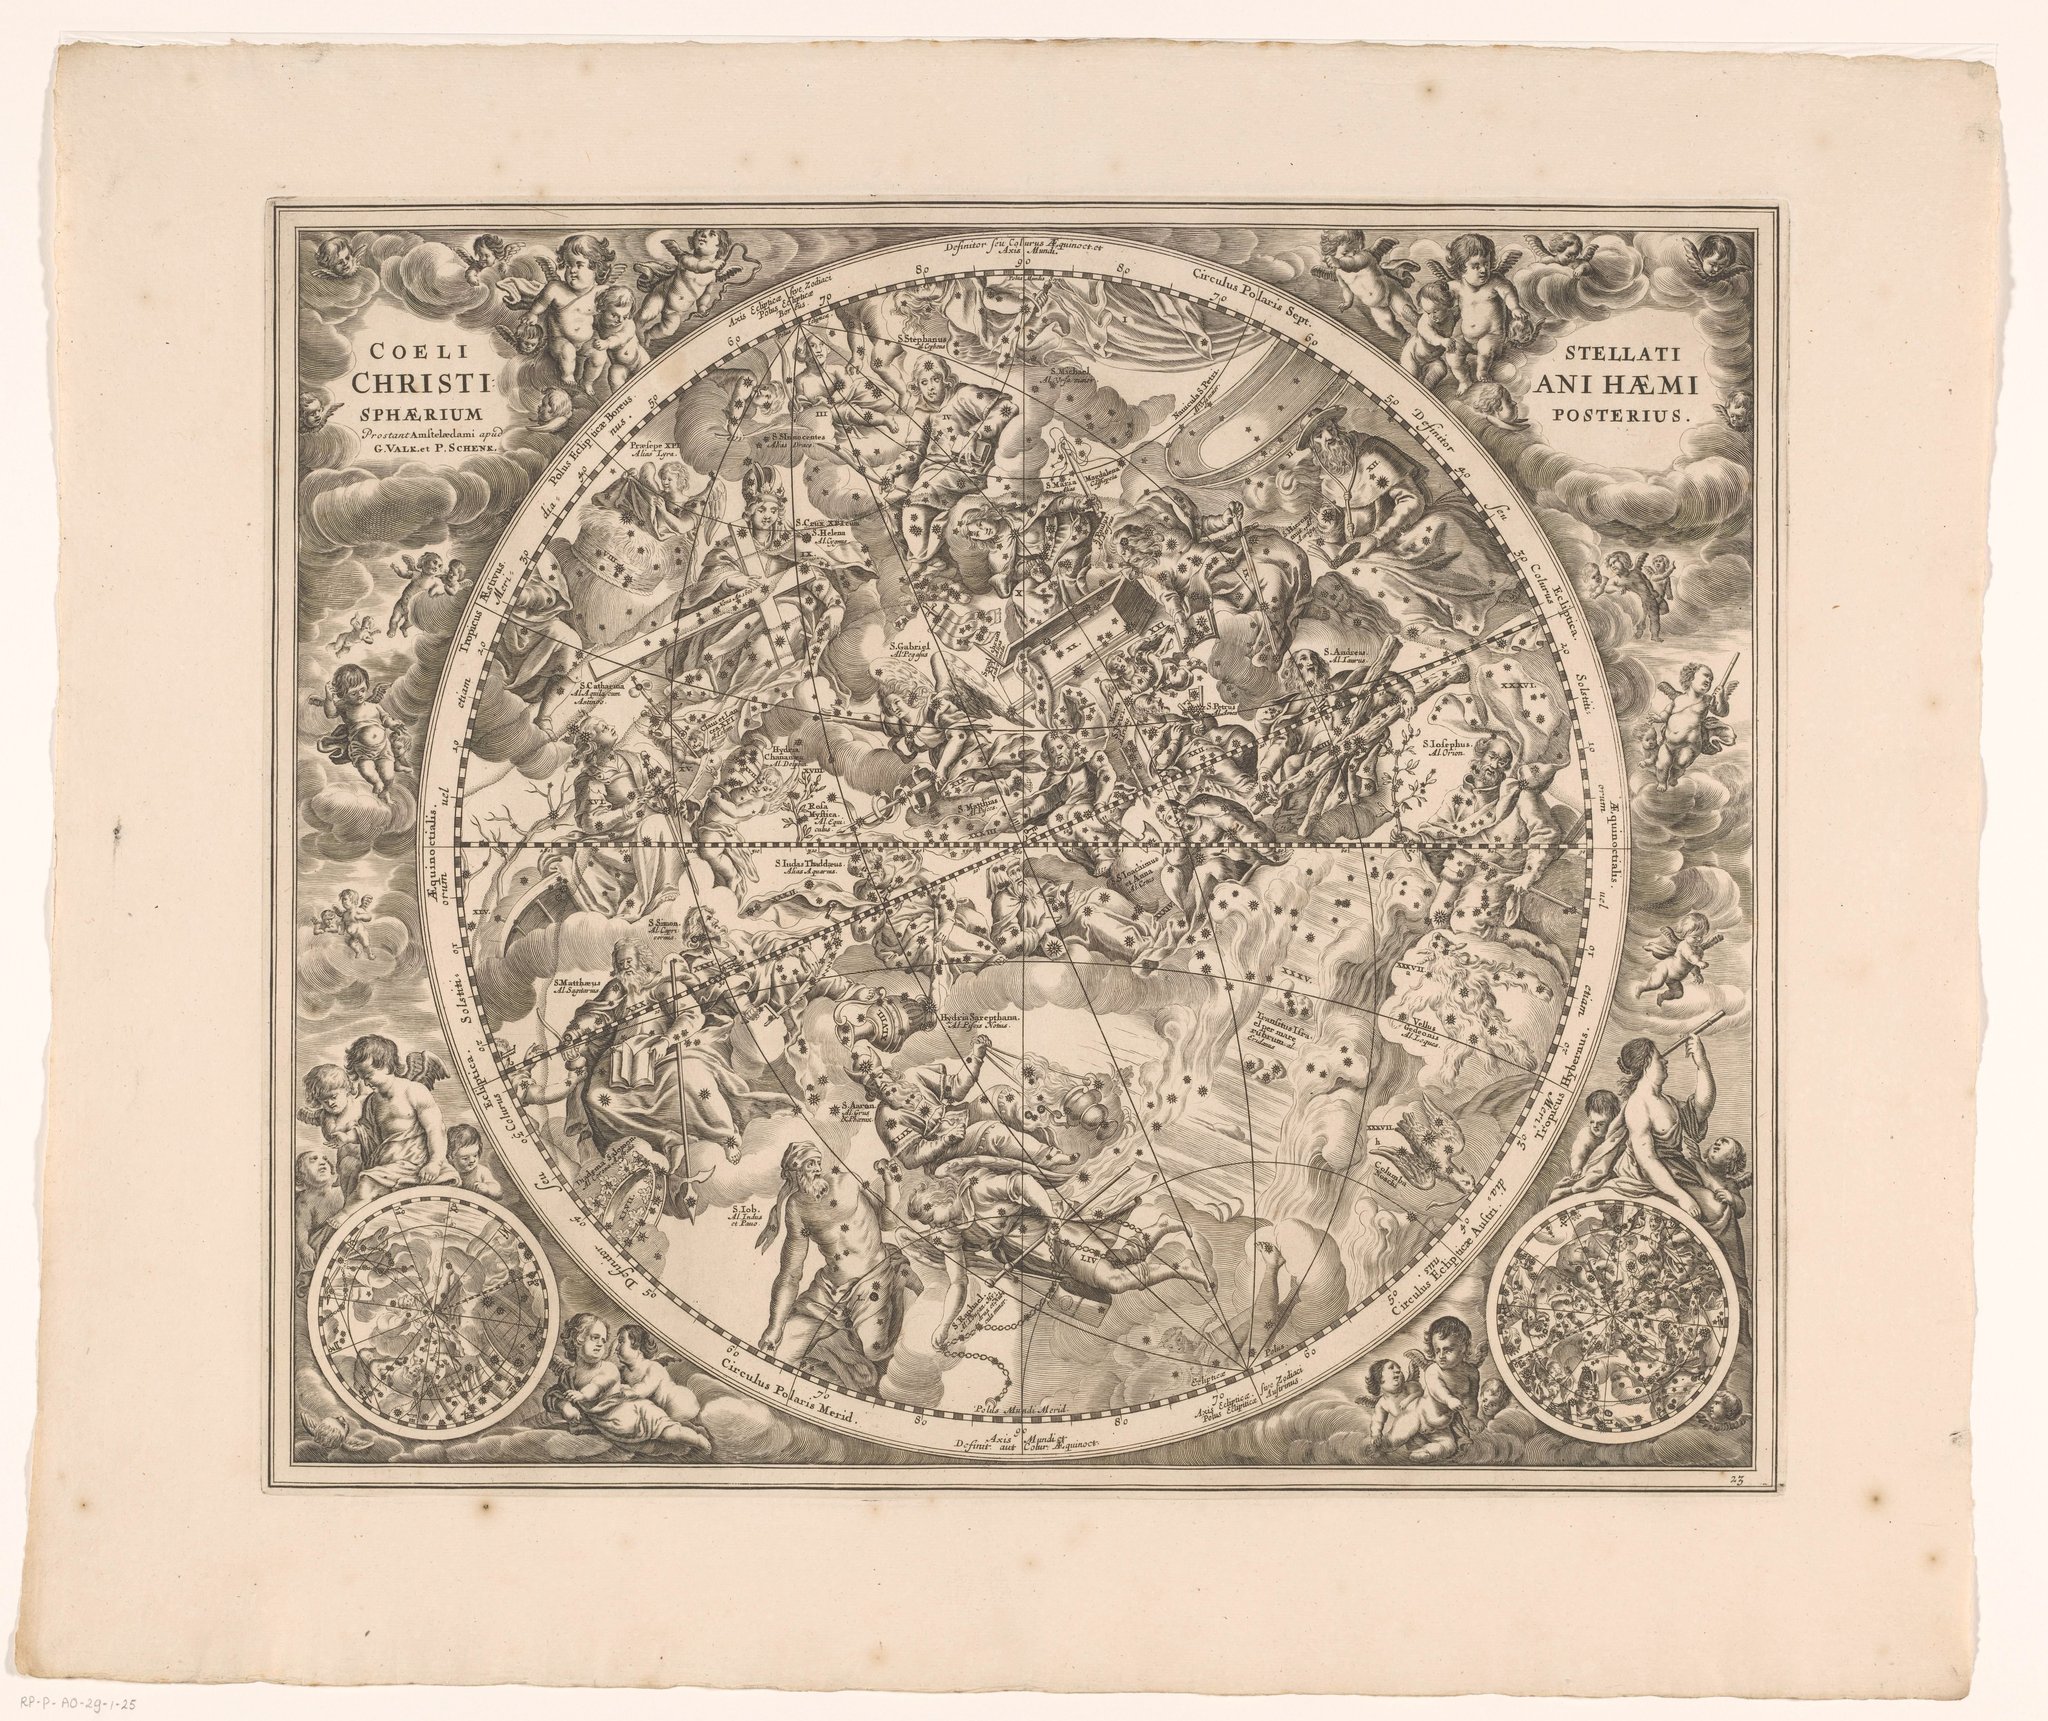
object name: map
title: Coelistellati Christiani haemisphaerium posterius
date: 1660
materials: paper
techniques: engraving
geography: amsterdam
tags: zodiac; the twelve zodiacal signs together, star-chart, star map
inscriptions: collector's mark: Lugt 2228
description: Hemelkaart van de najaarshemelsfeer met de Christelijke sterrenbeelden, gebaseerd op de atlas van Julius Schiller uit 1627. In plaats van de gebruikelijke sterrenbeelden in de dierenriem zijn apostelen te zien. Links- en rechtsonder twee bollen waarin delen van de kaart van dichterbij te zien zijn. Links- en rechtsboven de titel. Rechtsonder genummerd: 23.